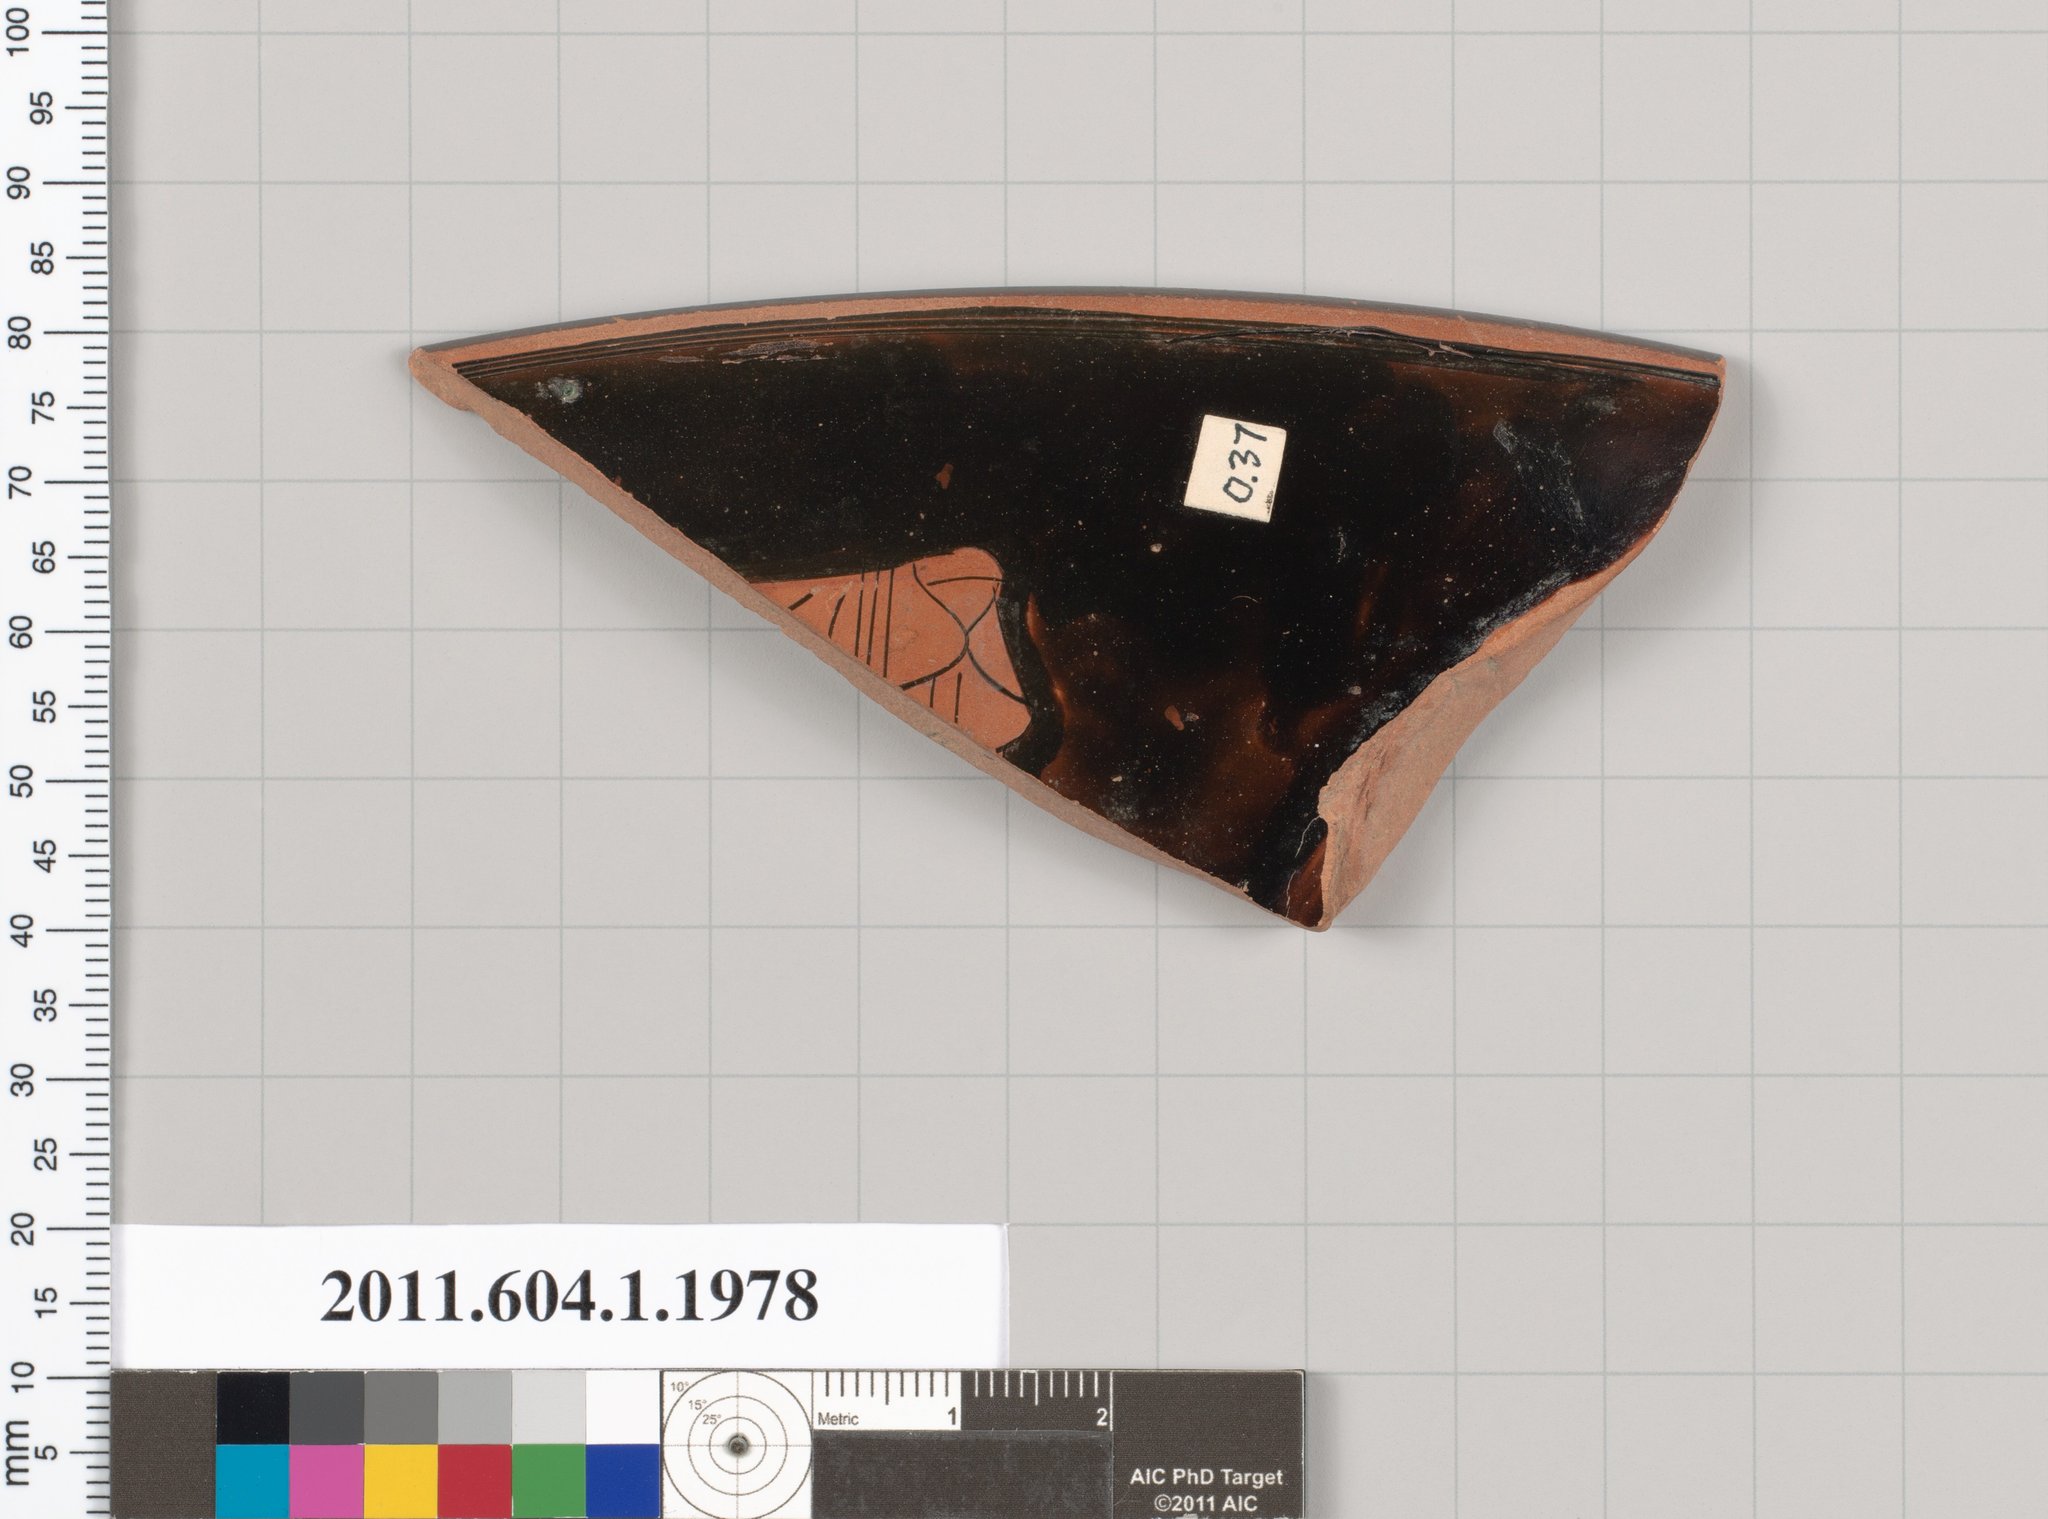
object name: kylix fragment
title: Terracotta rim fragment of a kylix (drinking cup)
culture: greek, attic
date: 475-451 BCE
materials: terracotta